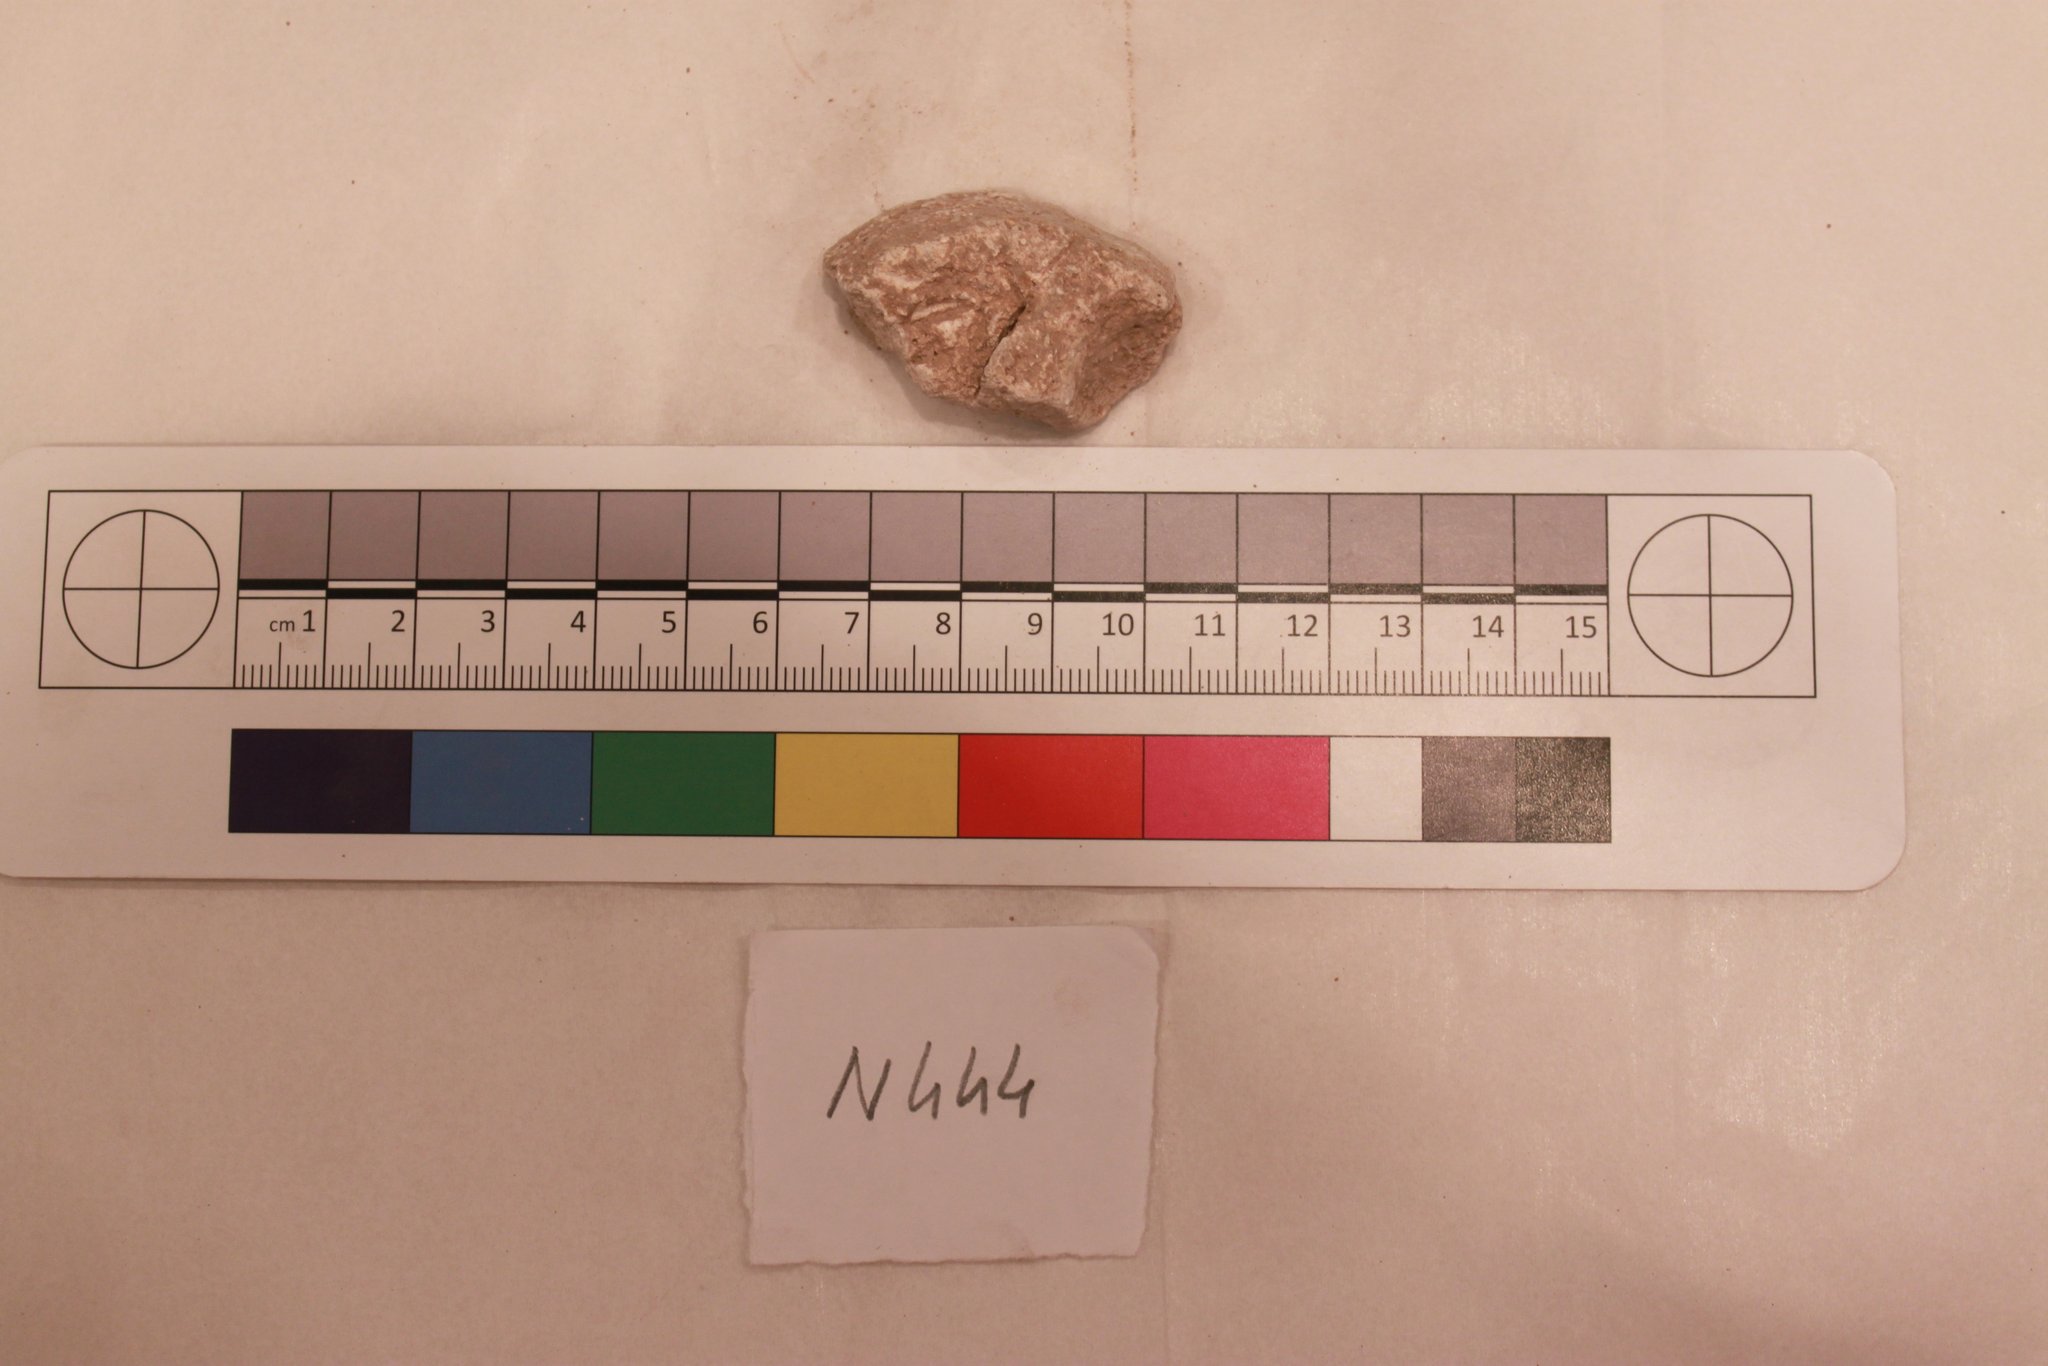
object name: fragment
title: Stucco Fragment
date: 701-1200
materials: plaster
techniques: carving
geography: iran